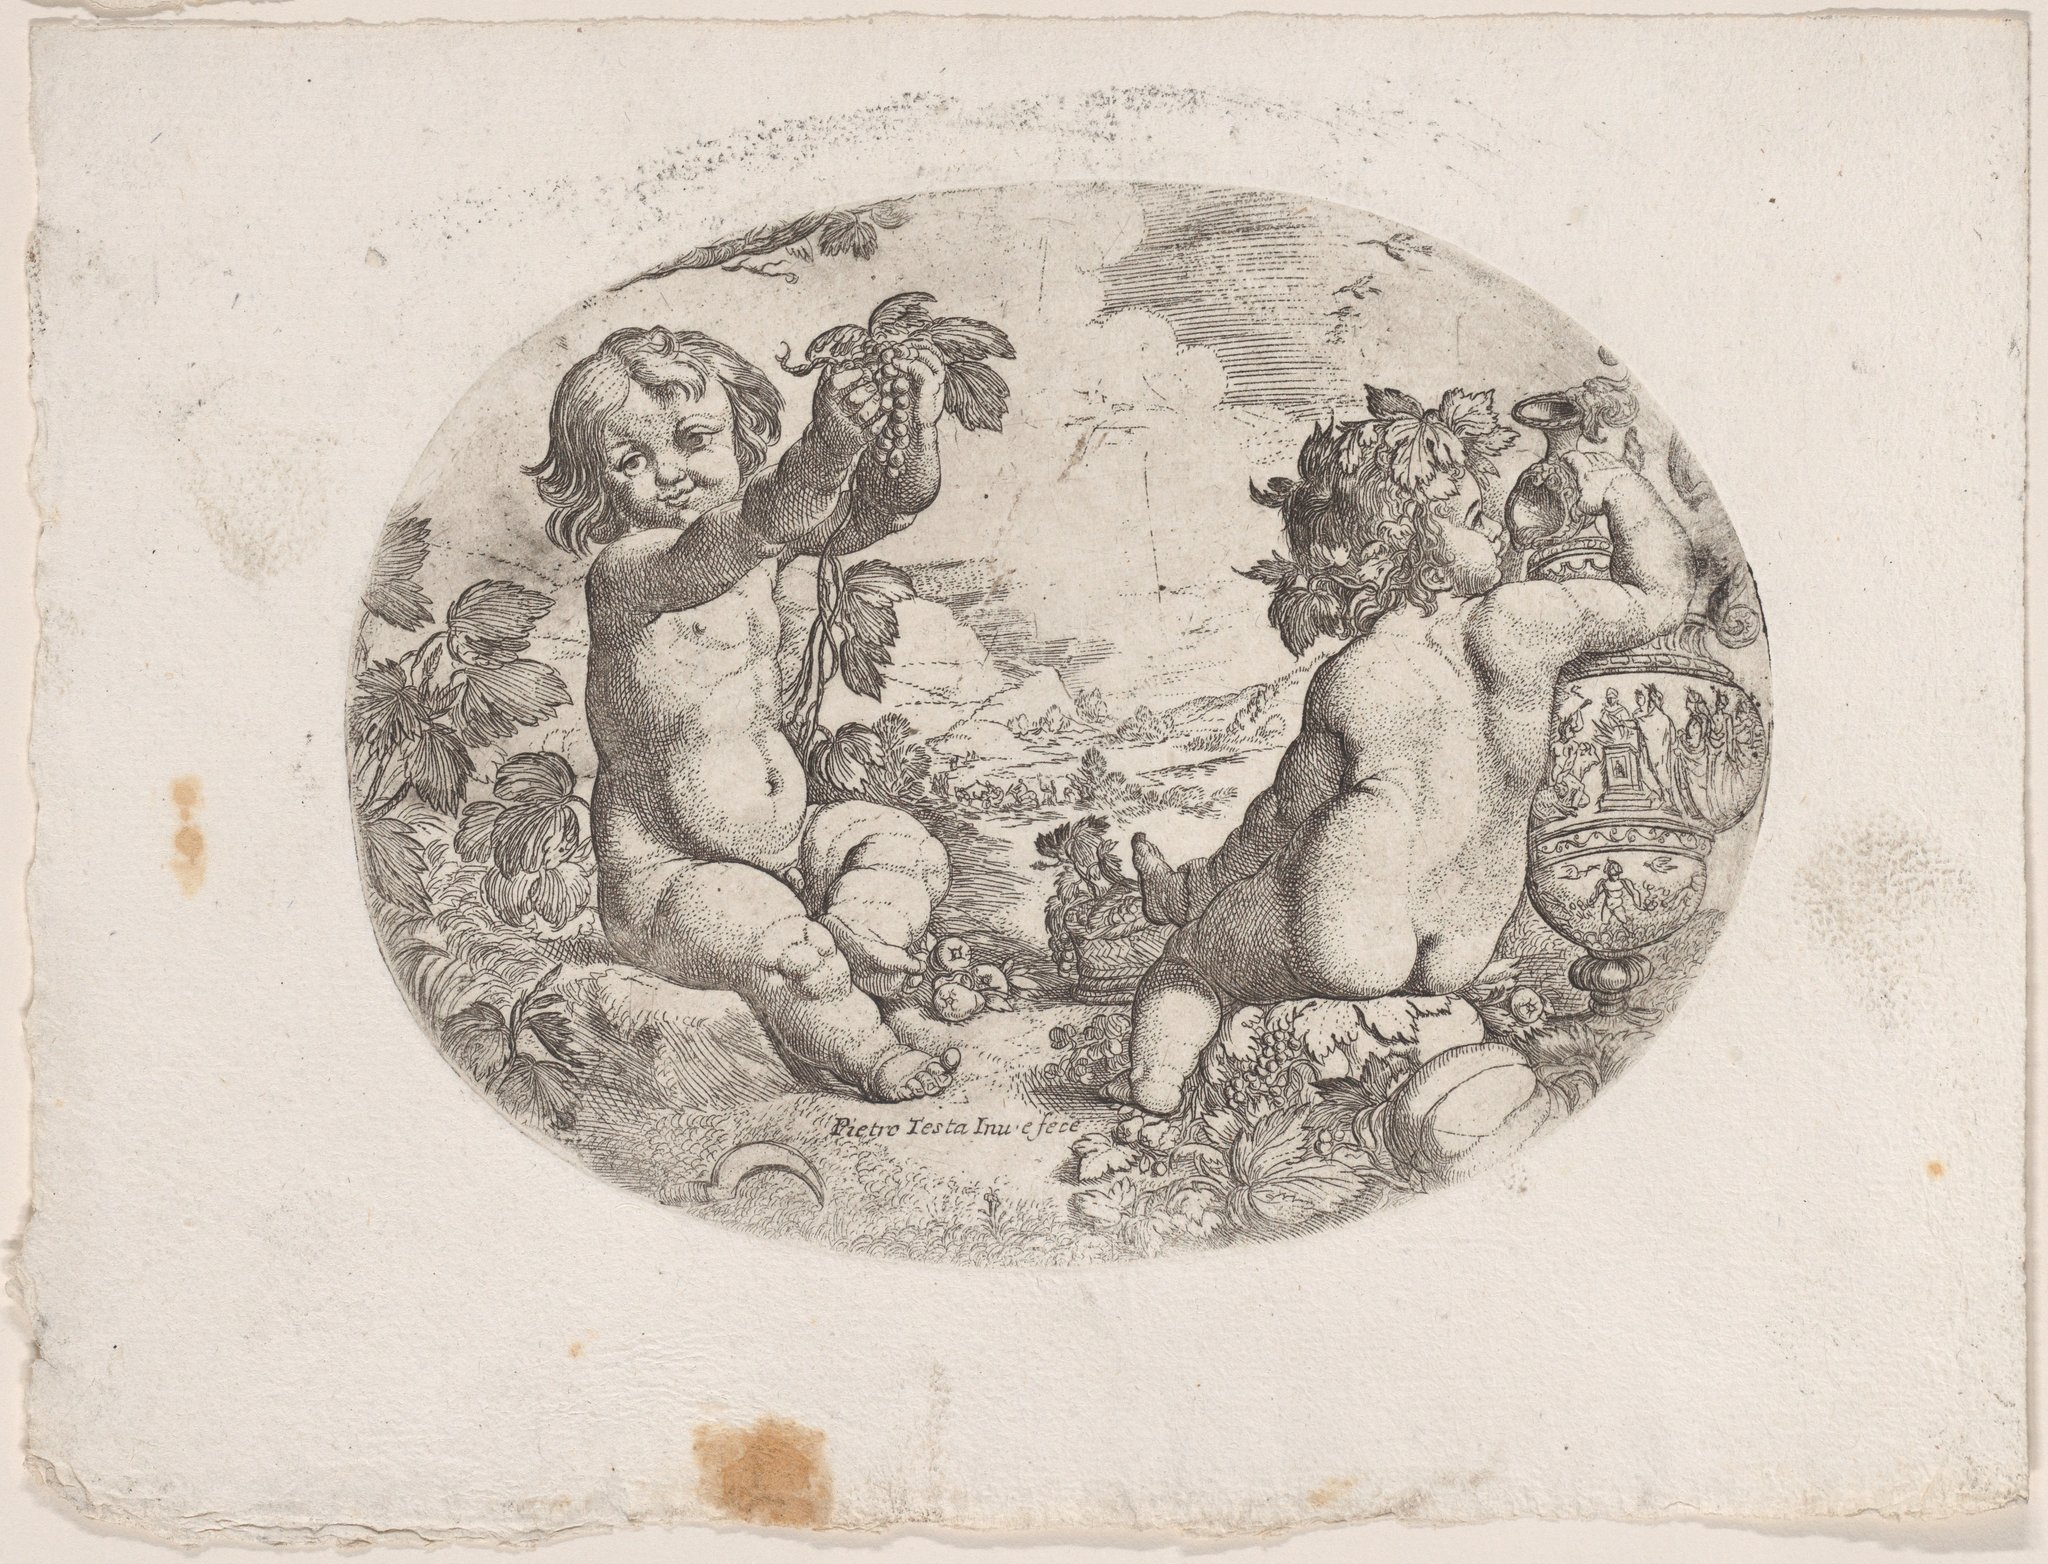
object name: print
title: Putto at the left hold aloft grapes,another seated at the right holding an urn, an allegory of the seasons (Summer), an oval composition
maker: anonymous, 17th century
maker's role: artist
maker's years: 1600-1700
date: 1650-1680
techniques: etching